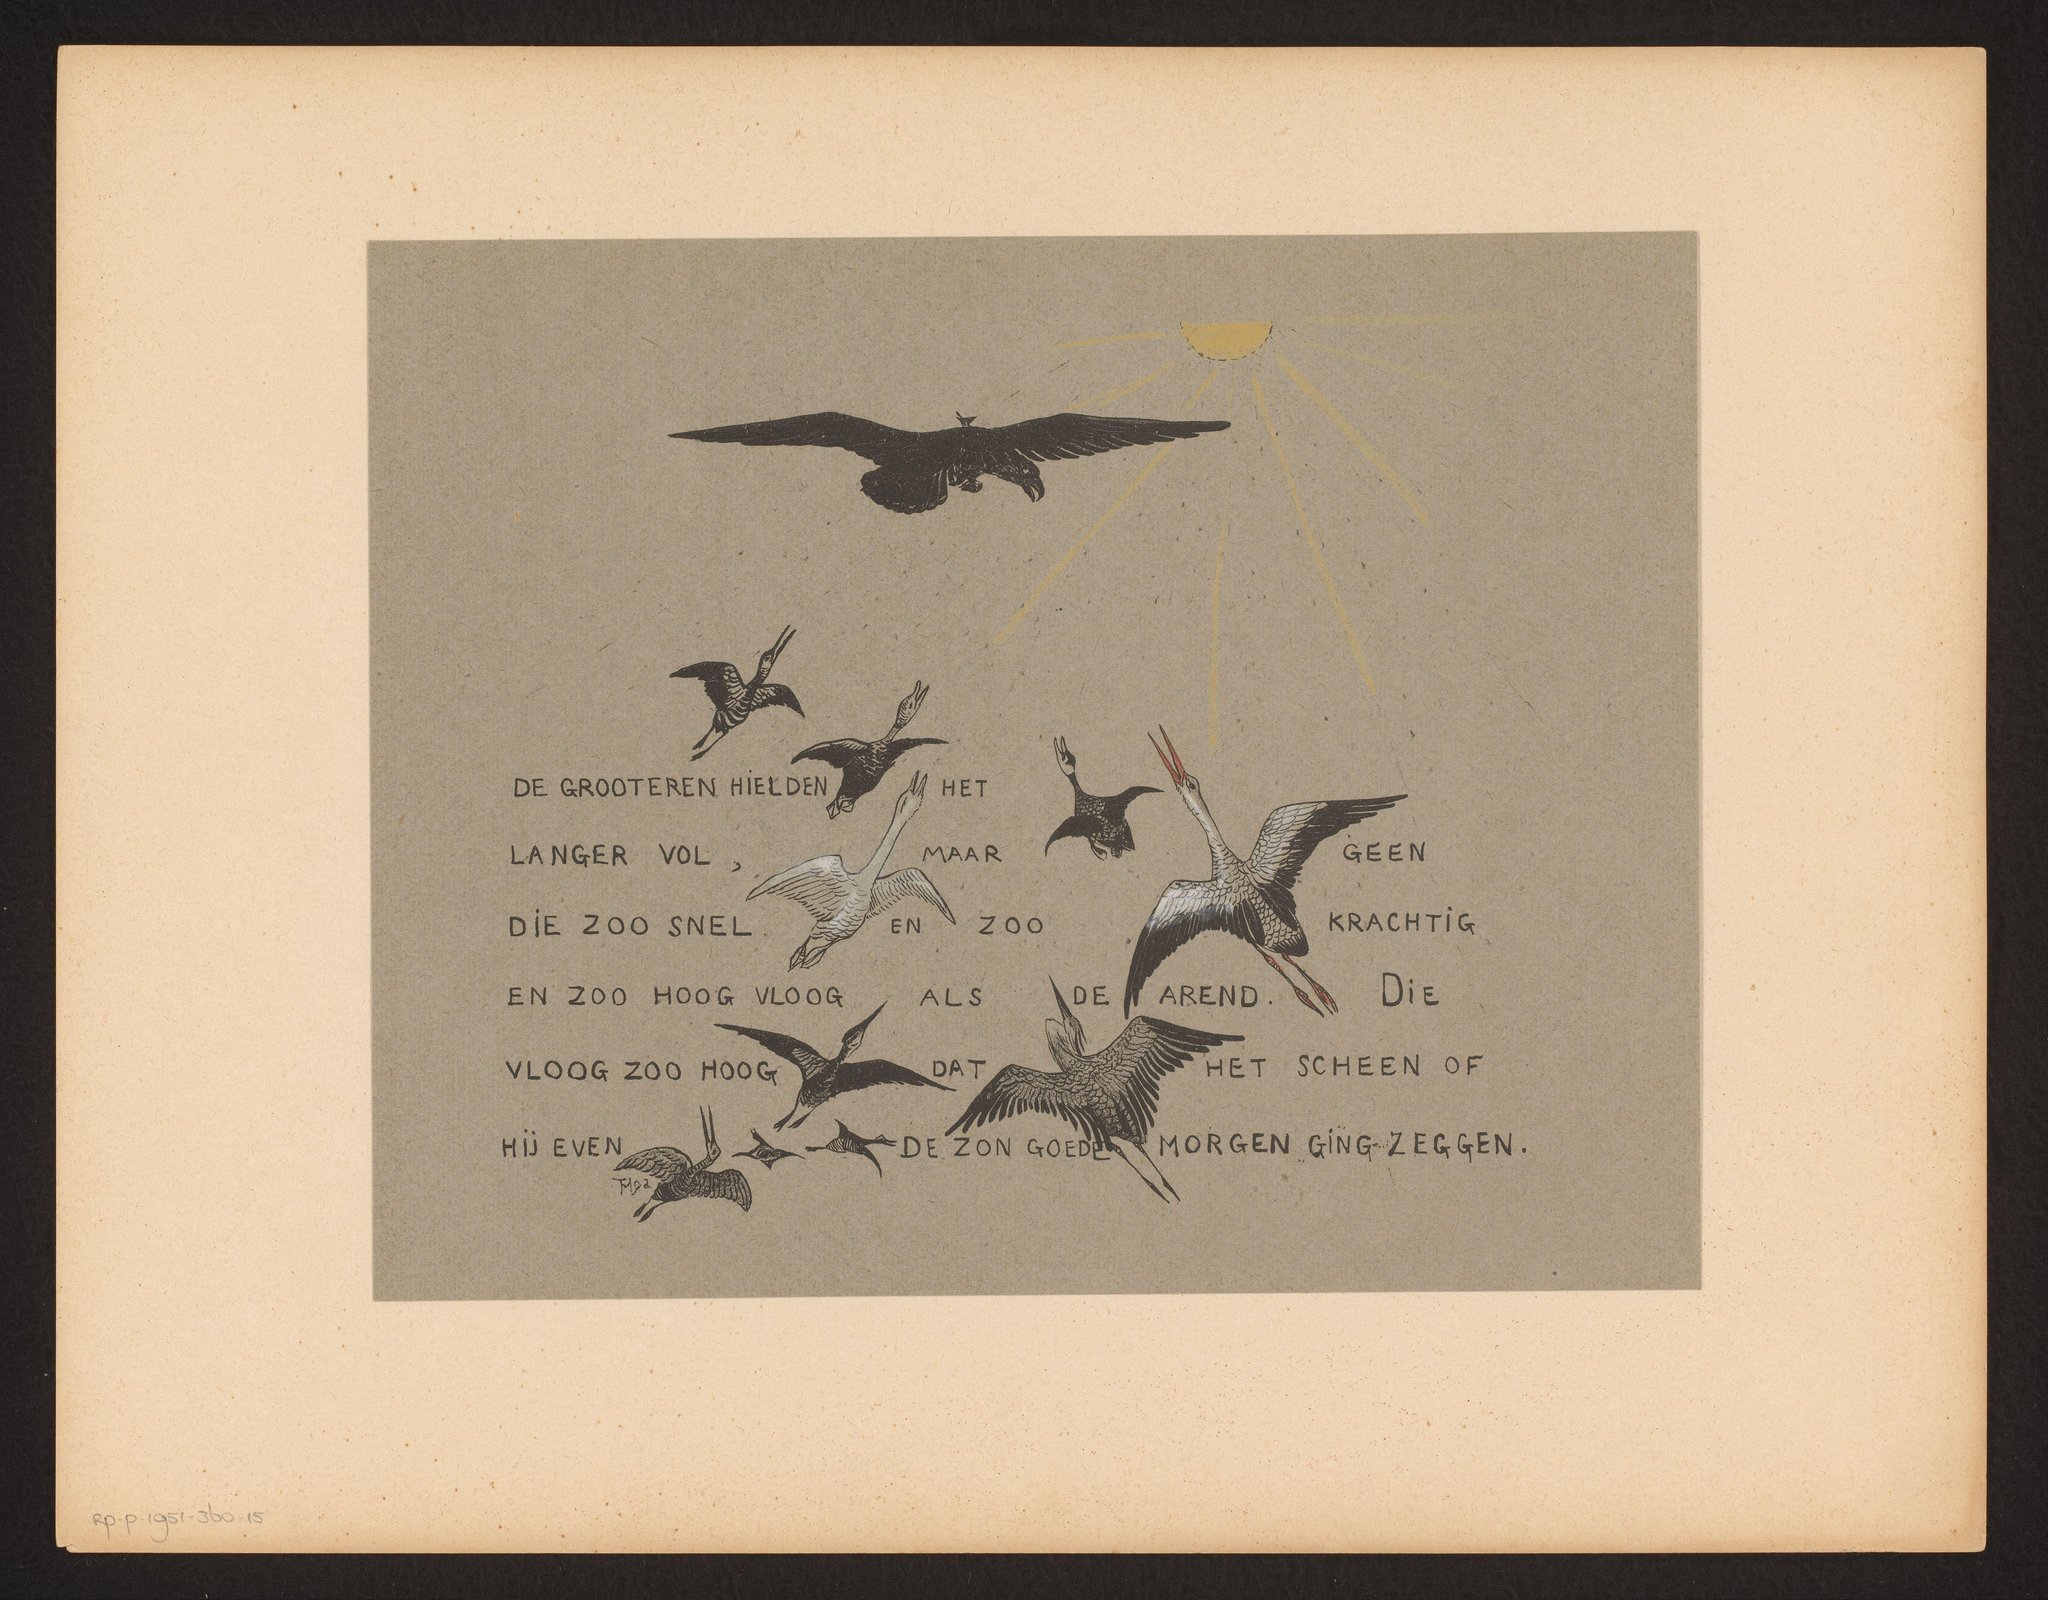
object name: print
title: Hoe de vogels aan een koning kwamen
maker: theo van hoytema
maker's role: draughtsman, painter, print maker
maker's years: 1863-1917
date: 1892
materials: paper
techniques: hand coloring, lithograph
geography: the hague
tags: predatory birds: eagle, shore-birds and wading-birds: stork, shore-birds and wading-birds: heron, song-birds: wren, sun as celestial body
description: Onder andere een gans, een reiger en een ooievaar vliegen achter een arend aan (met een winterkoning op de rug), richting de zon.